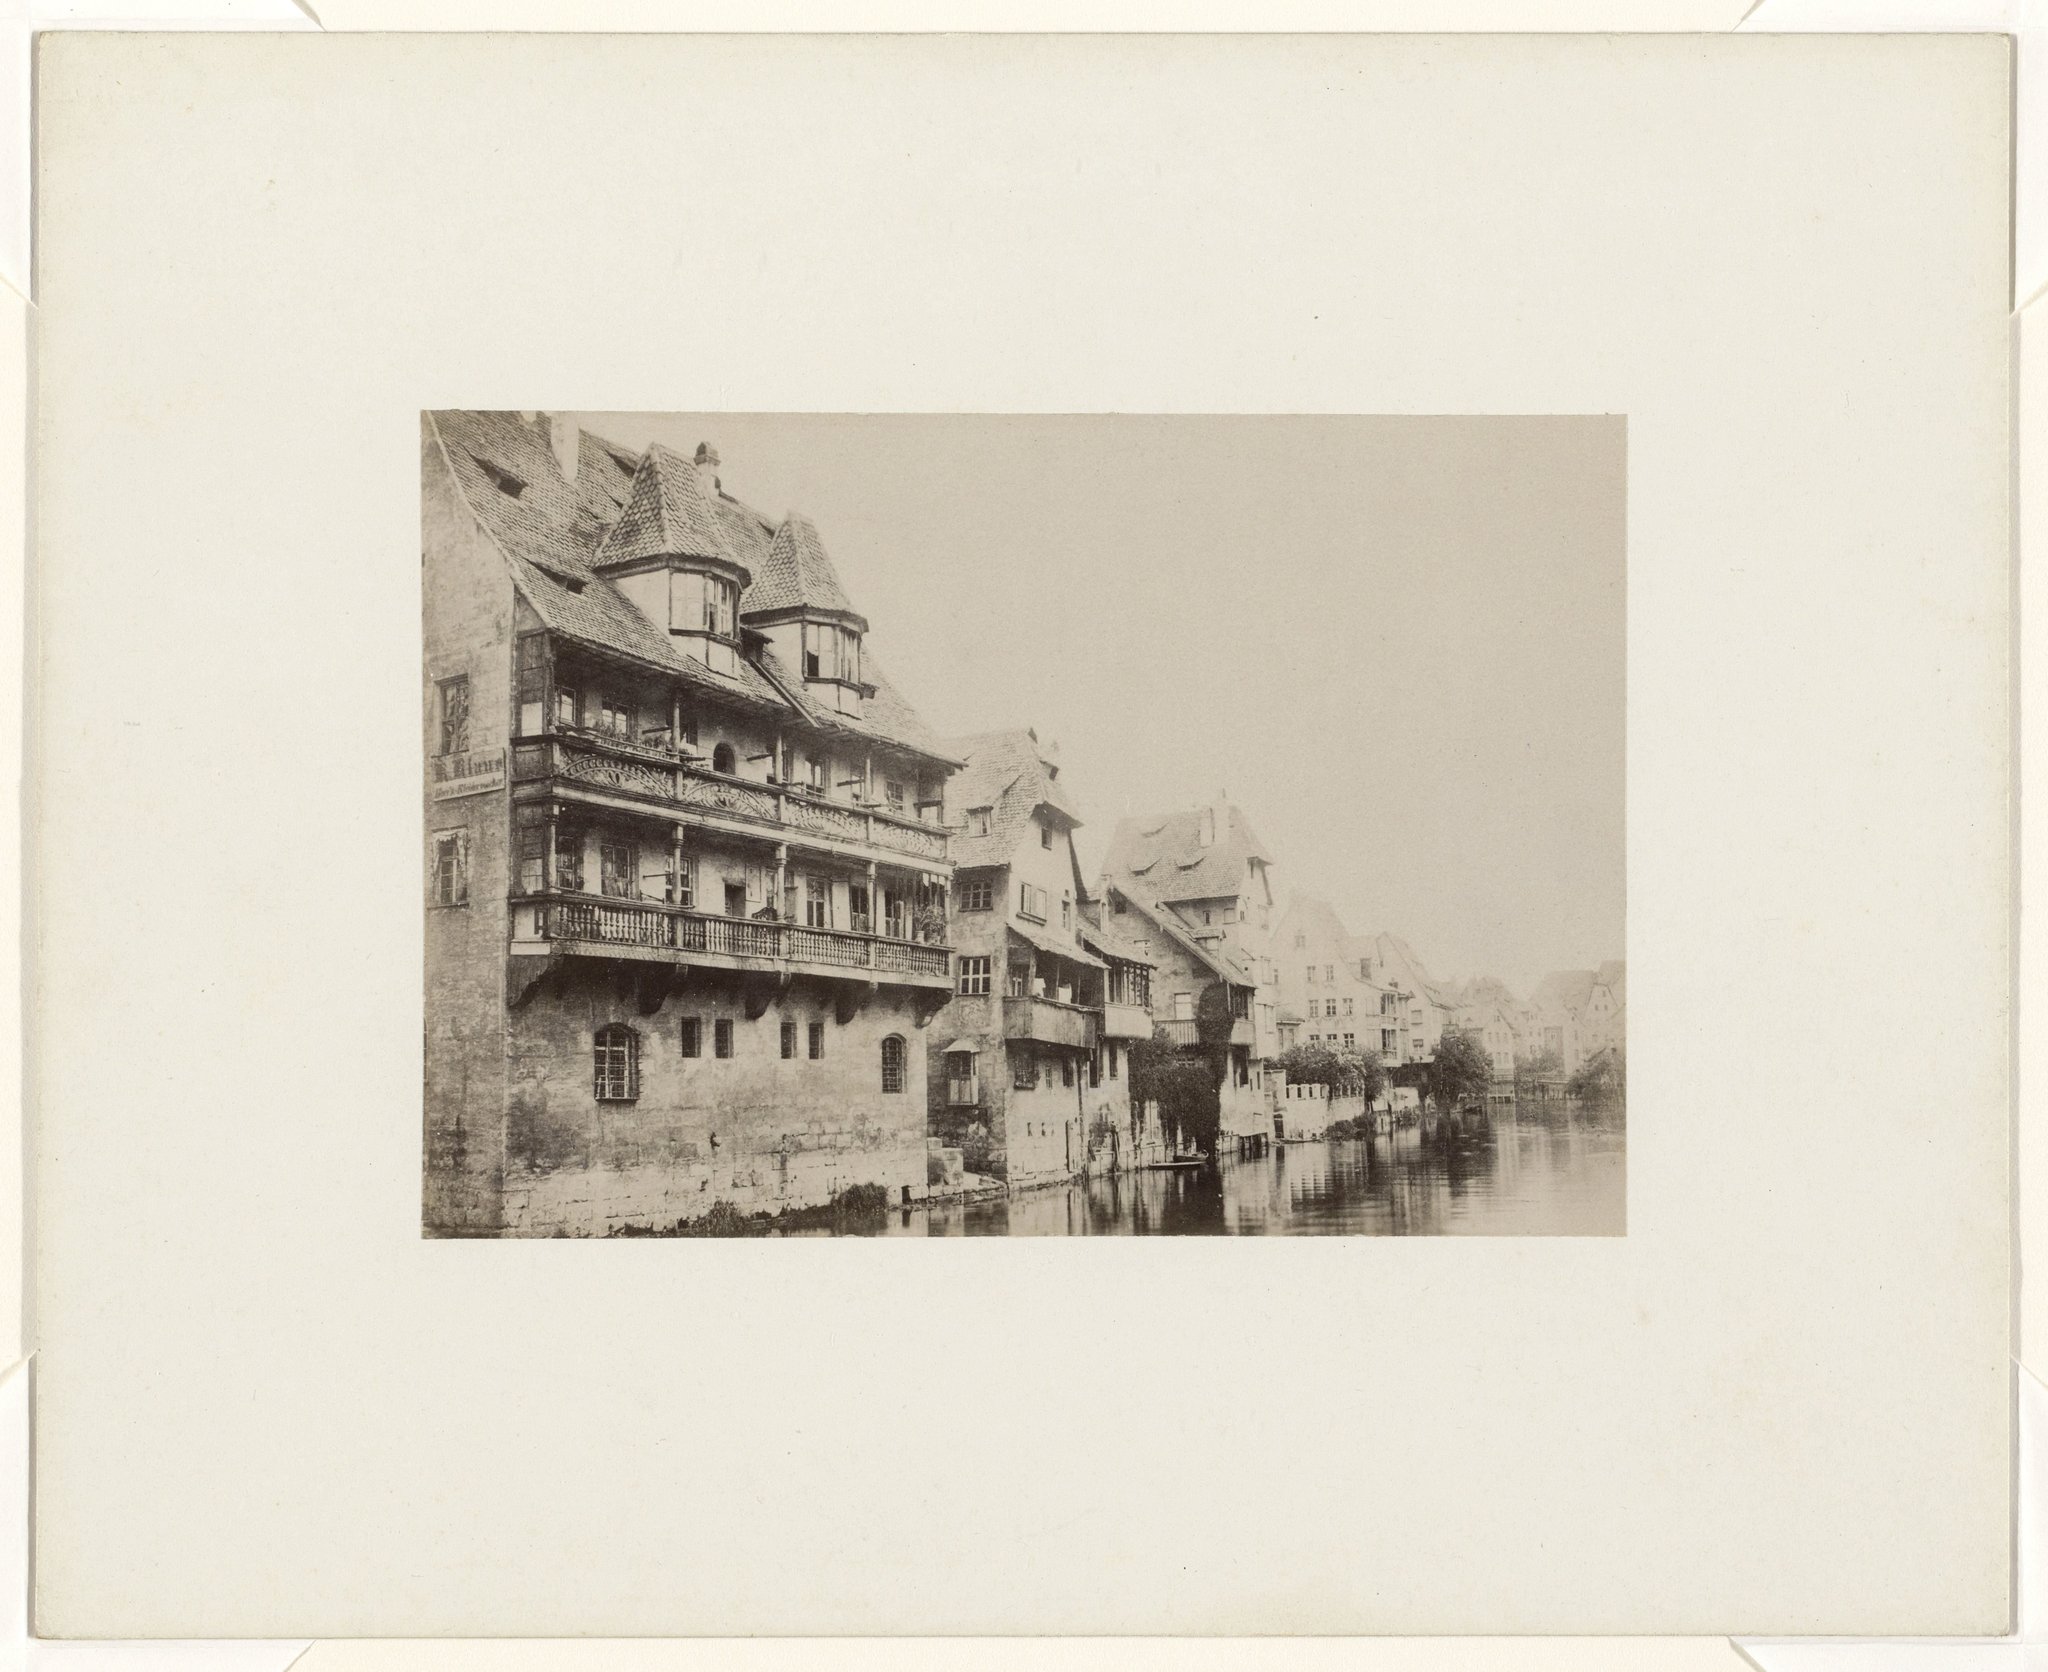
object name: photograph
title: Huizen aan de Pegnitz in Neurenberg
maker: Anonymous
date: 1860-1890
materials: cardboard, paper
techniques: albumen print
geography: nuremberg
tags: canals, waters (in city)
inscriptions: inscription: ‘Nürnberg’